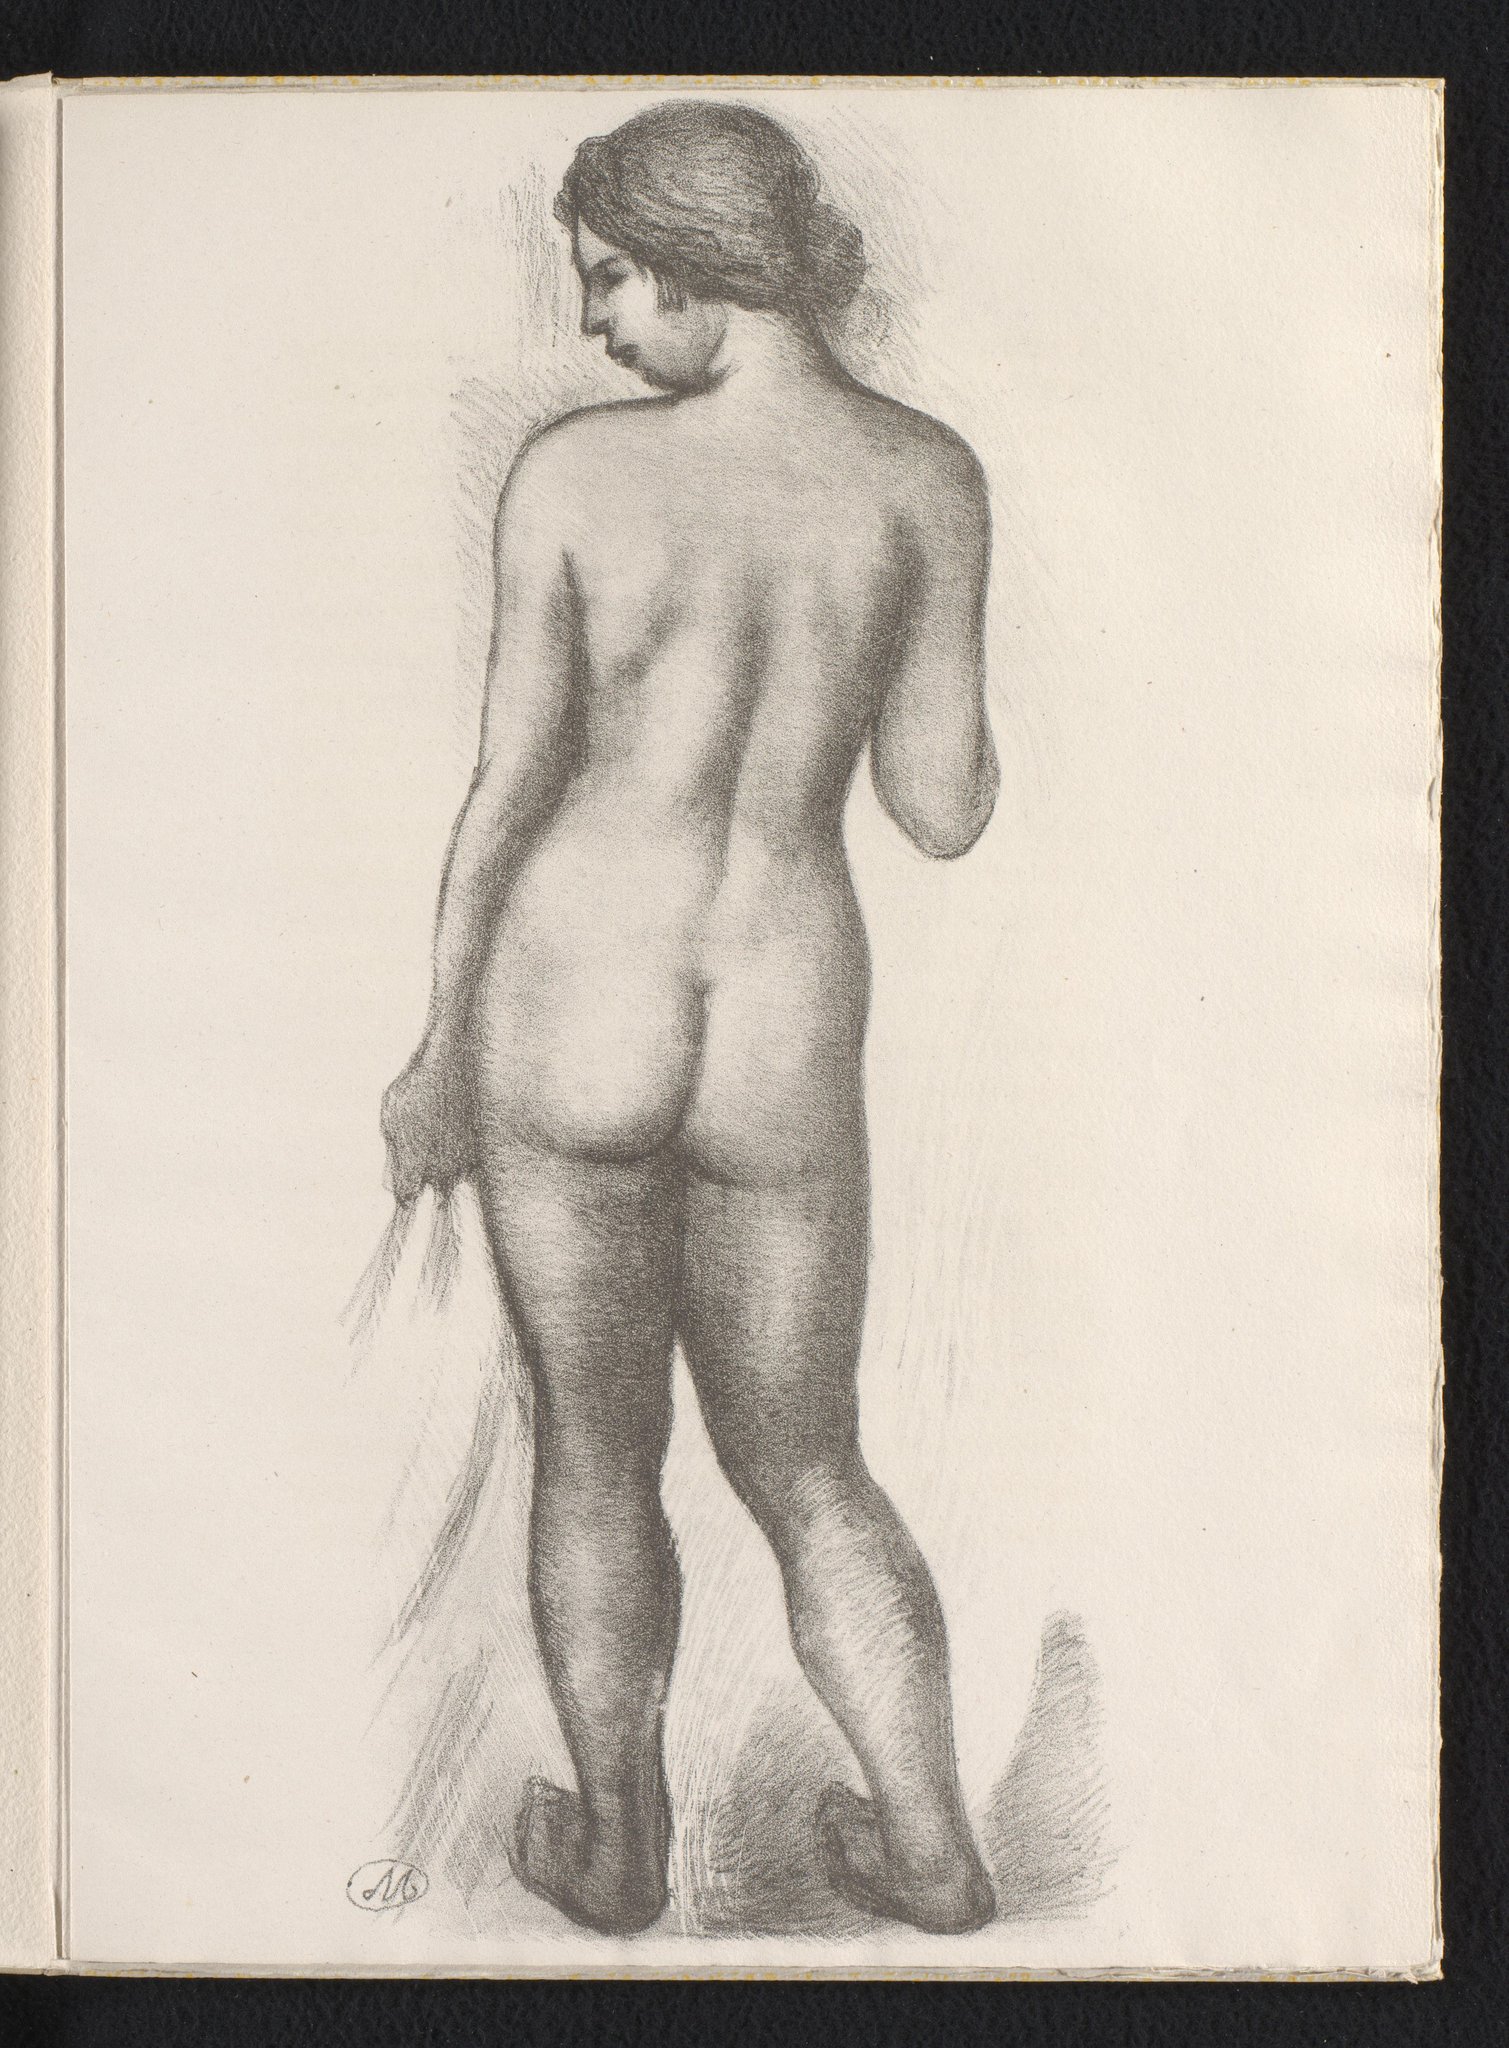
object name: page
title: Staande naakte vrouw, op de rug gezien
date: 1935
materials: paper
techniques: letterpress printing, lithograph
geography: lausanne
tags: woman (showing herself) undressed, quasi-nude, standing figure - aa - female human figure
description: Prent in: Ovidius Naso, Publius. L'art d'aimer. [Vertaald uit het Latijn door] Henri Bornecque. Parijs/Lausanne: Les frères Gonin, 1935, na p. 116.